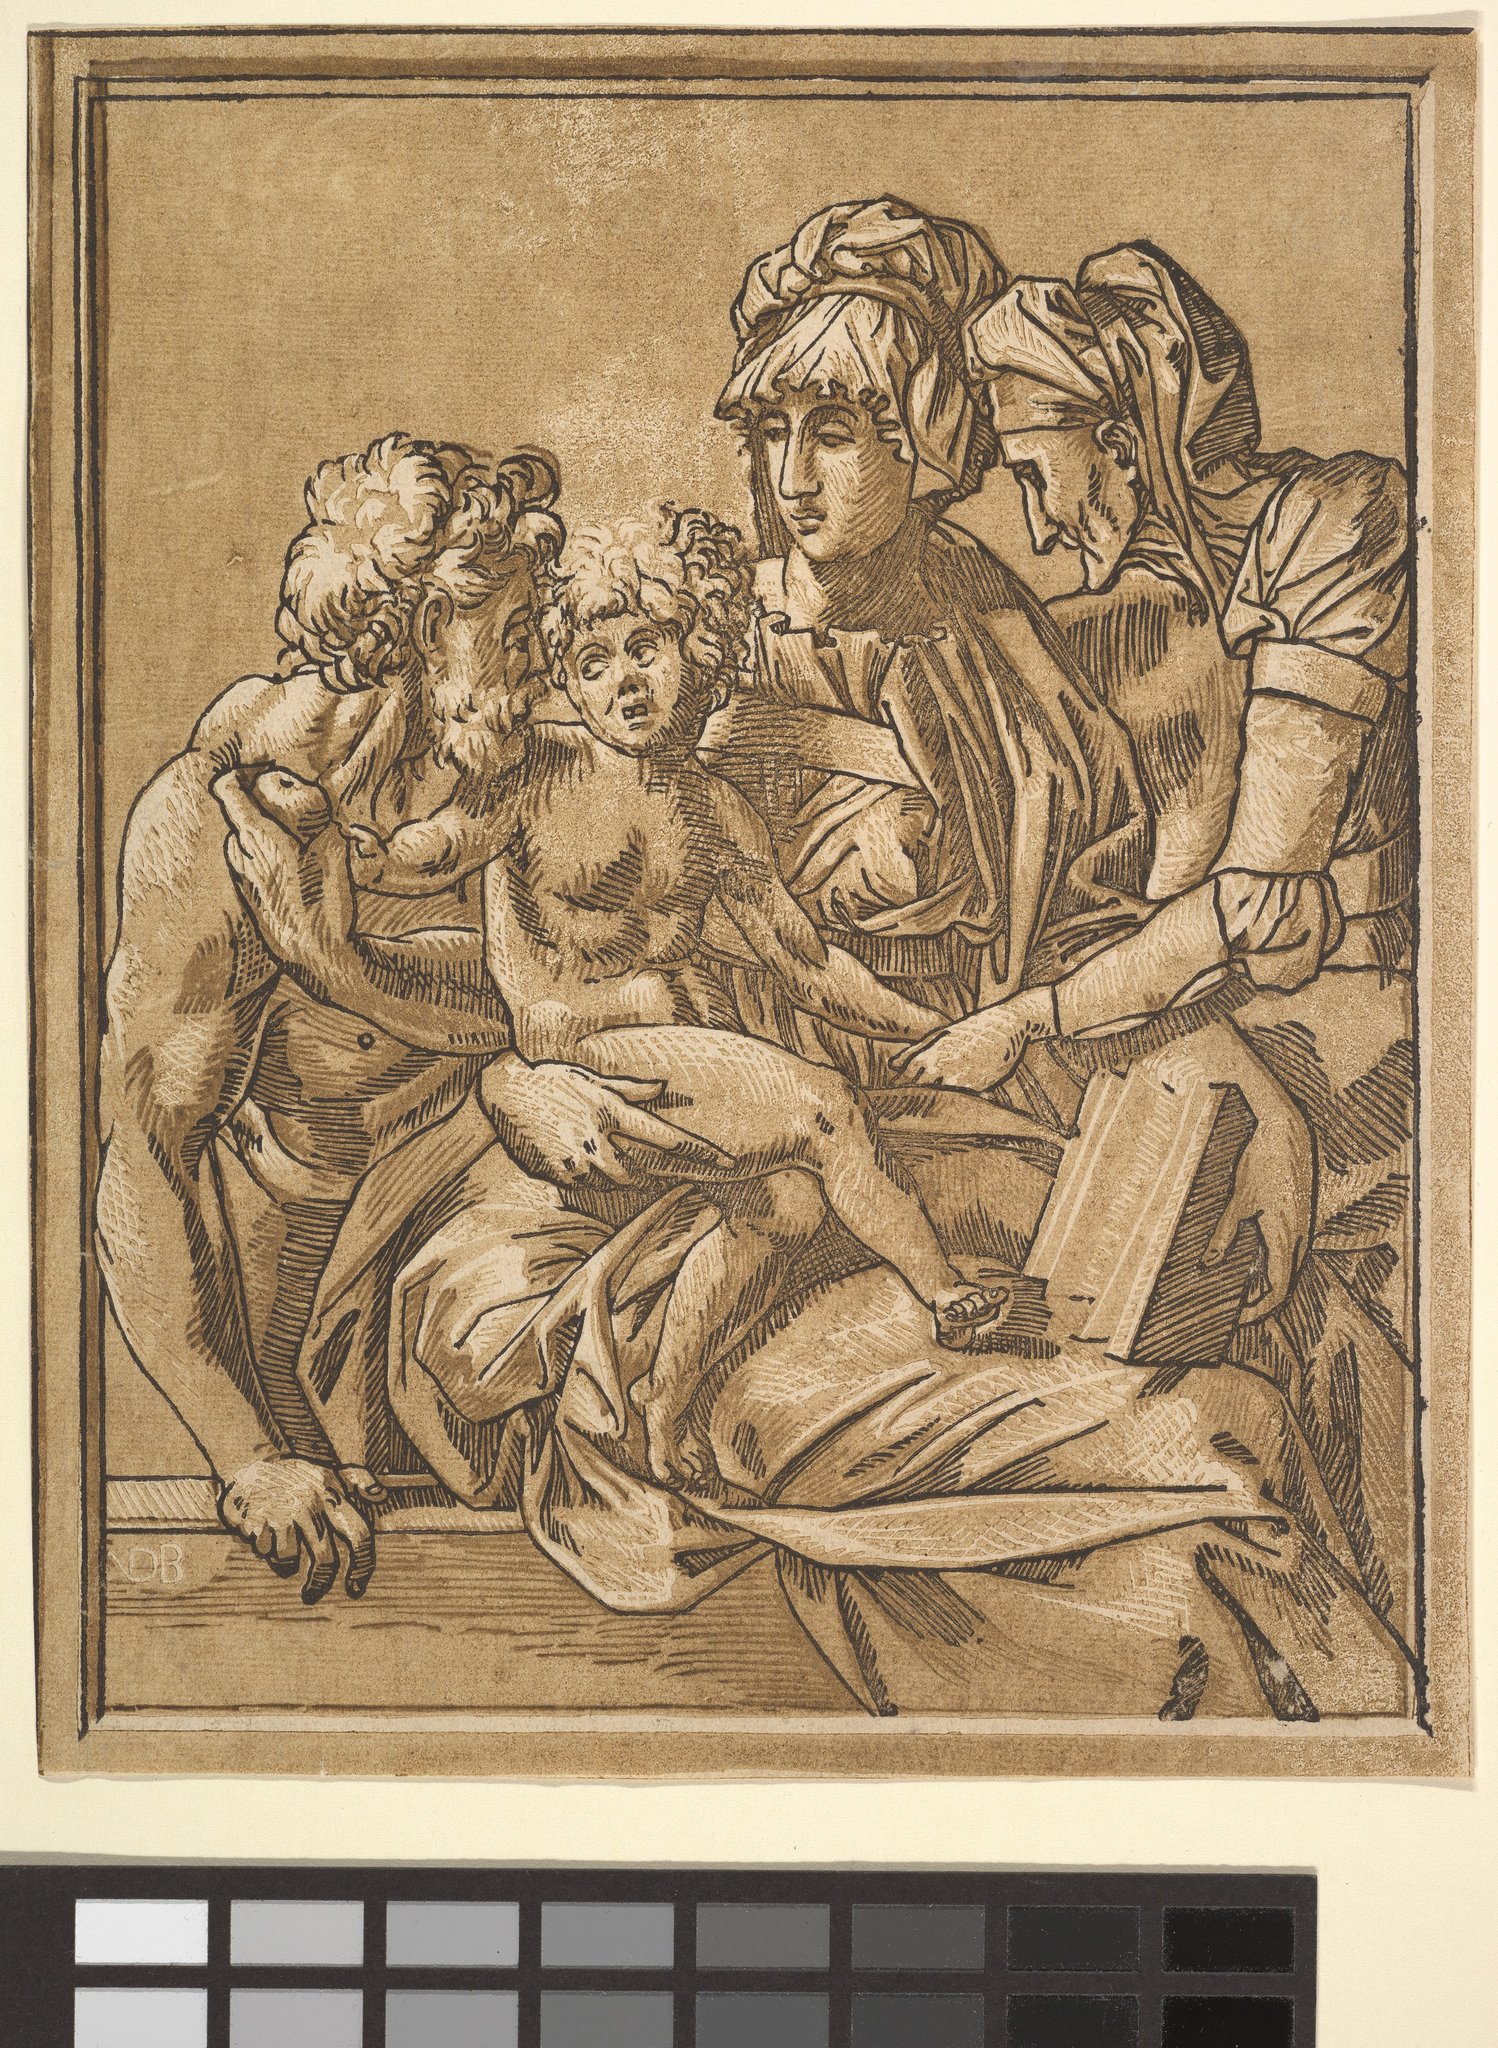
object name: print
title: Holy Family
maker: master nd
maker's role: artist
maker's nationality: italian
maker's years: 1540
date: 1544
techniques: woodcut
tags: christ,holy family,saint joseph,virgin mary